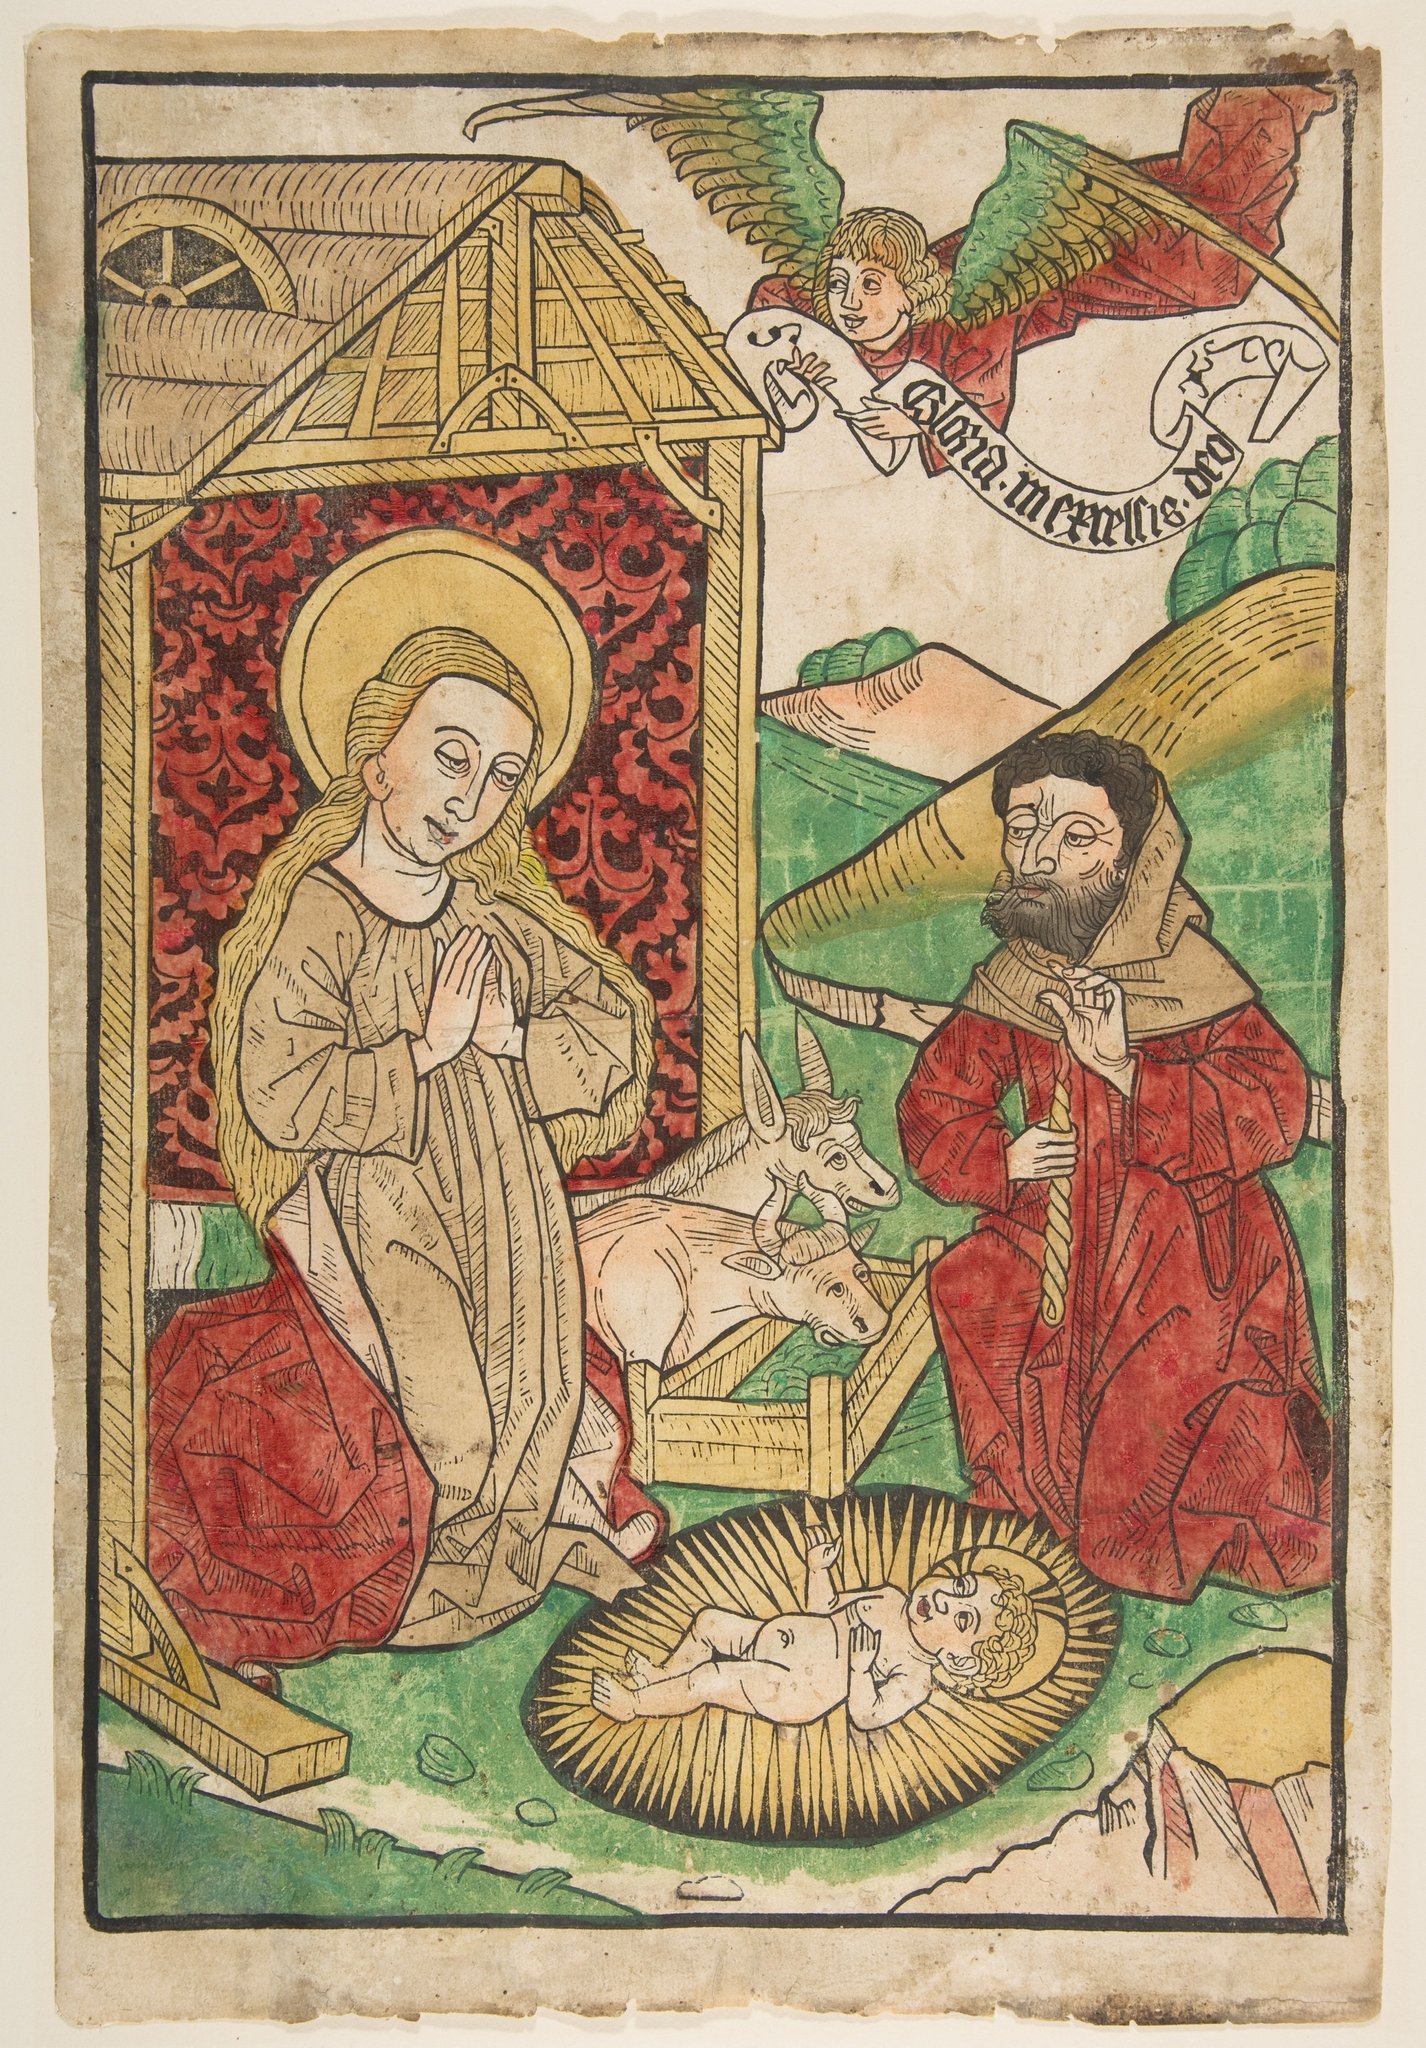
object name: print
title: The Nativity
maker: wolfgang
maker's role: artist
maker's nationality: german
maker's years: 1450-1500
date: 1470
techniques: hand coloring, woodcut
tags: animals,angels,virgin mary,jesus,nativity